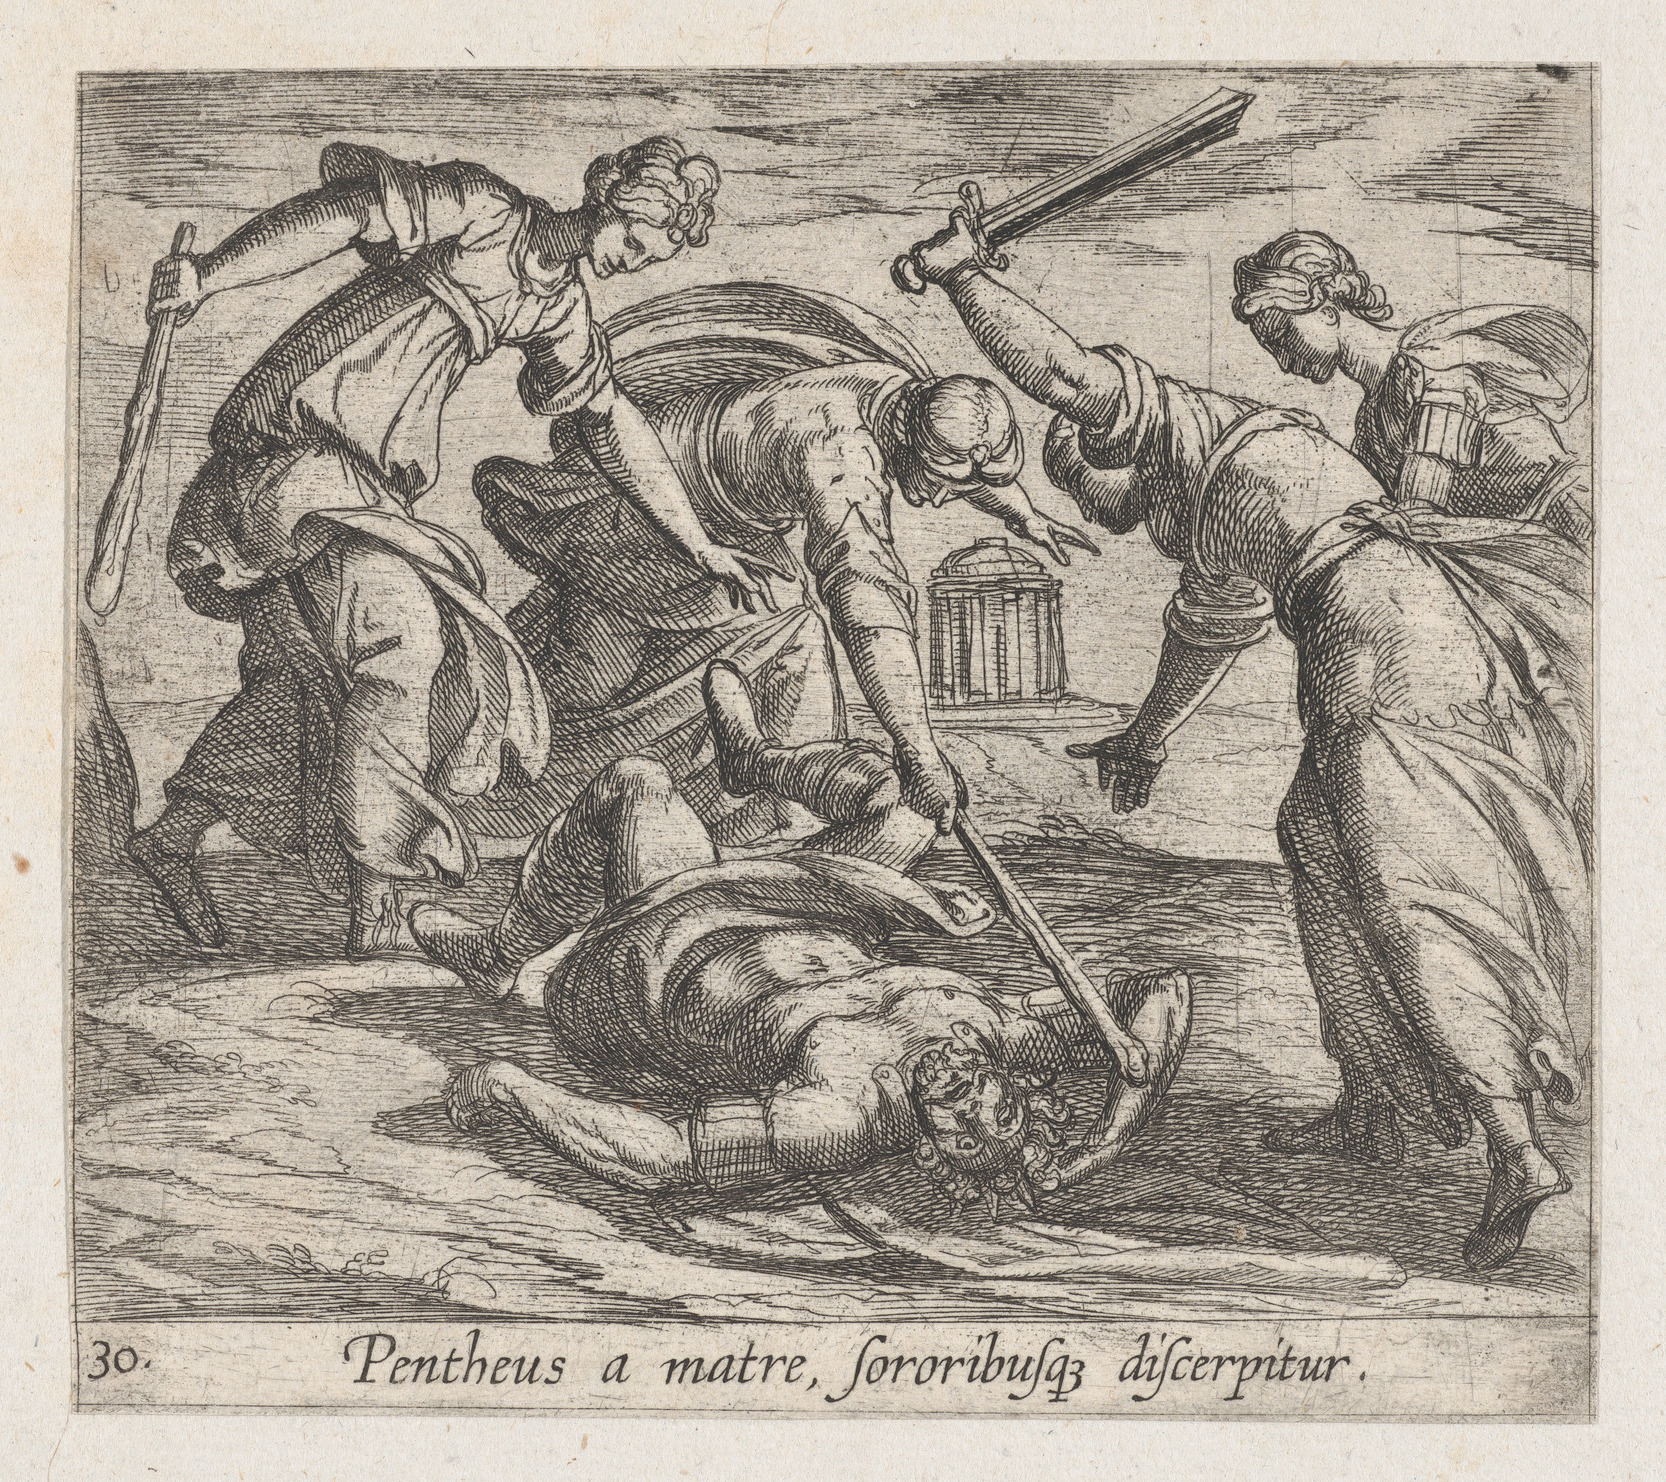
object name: print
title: Plate 30: The Death of Pentheus (Pentheus a matre, sororibusq discerpitur), from Ovid's 'Metamorphoses'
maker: antonio tempesta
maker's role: artist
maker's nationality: italian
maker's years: 1555-1630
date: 1606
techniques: etching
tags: men,women